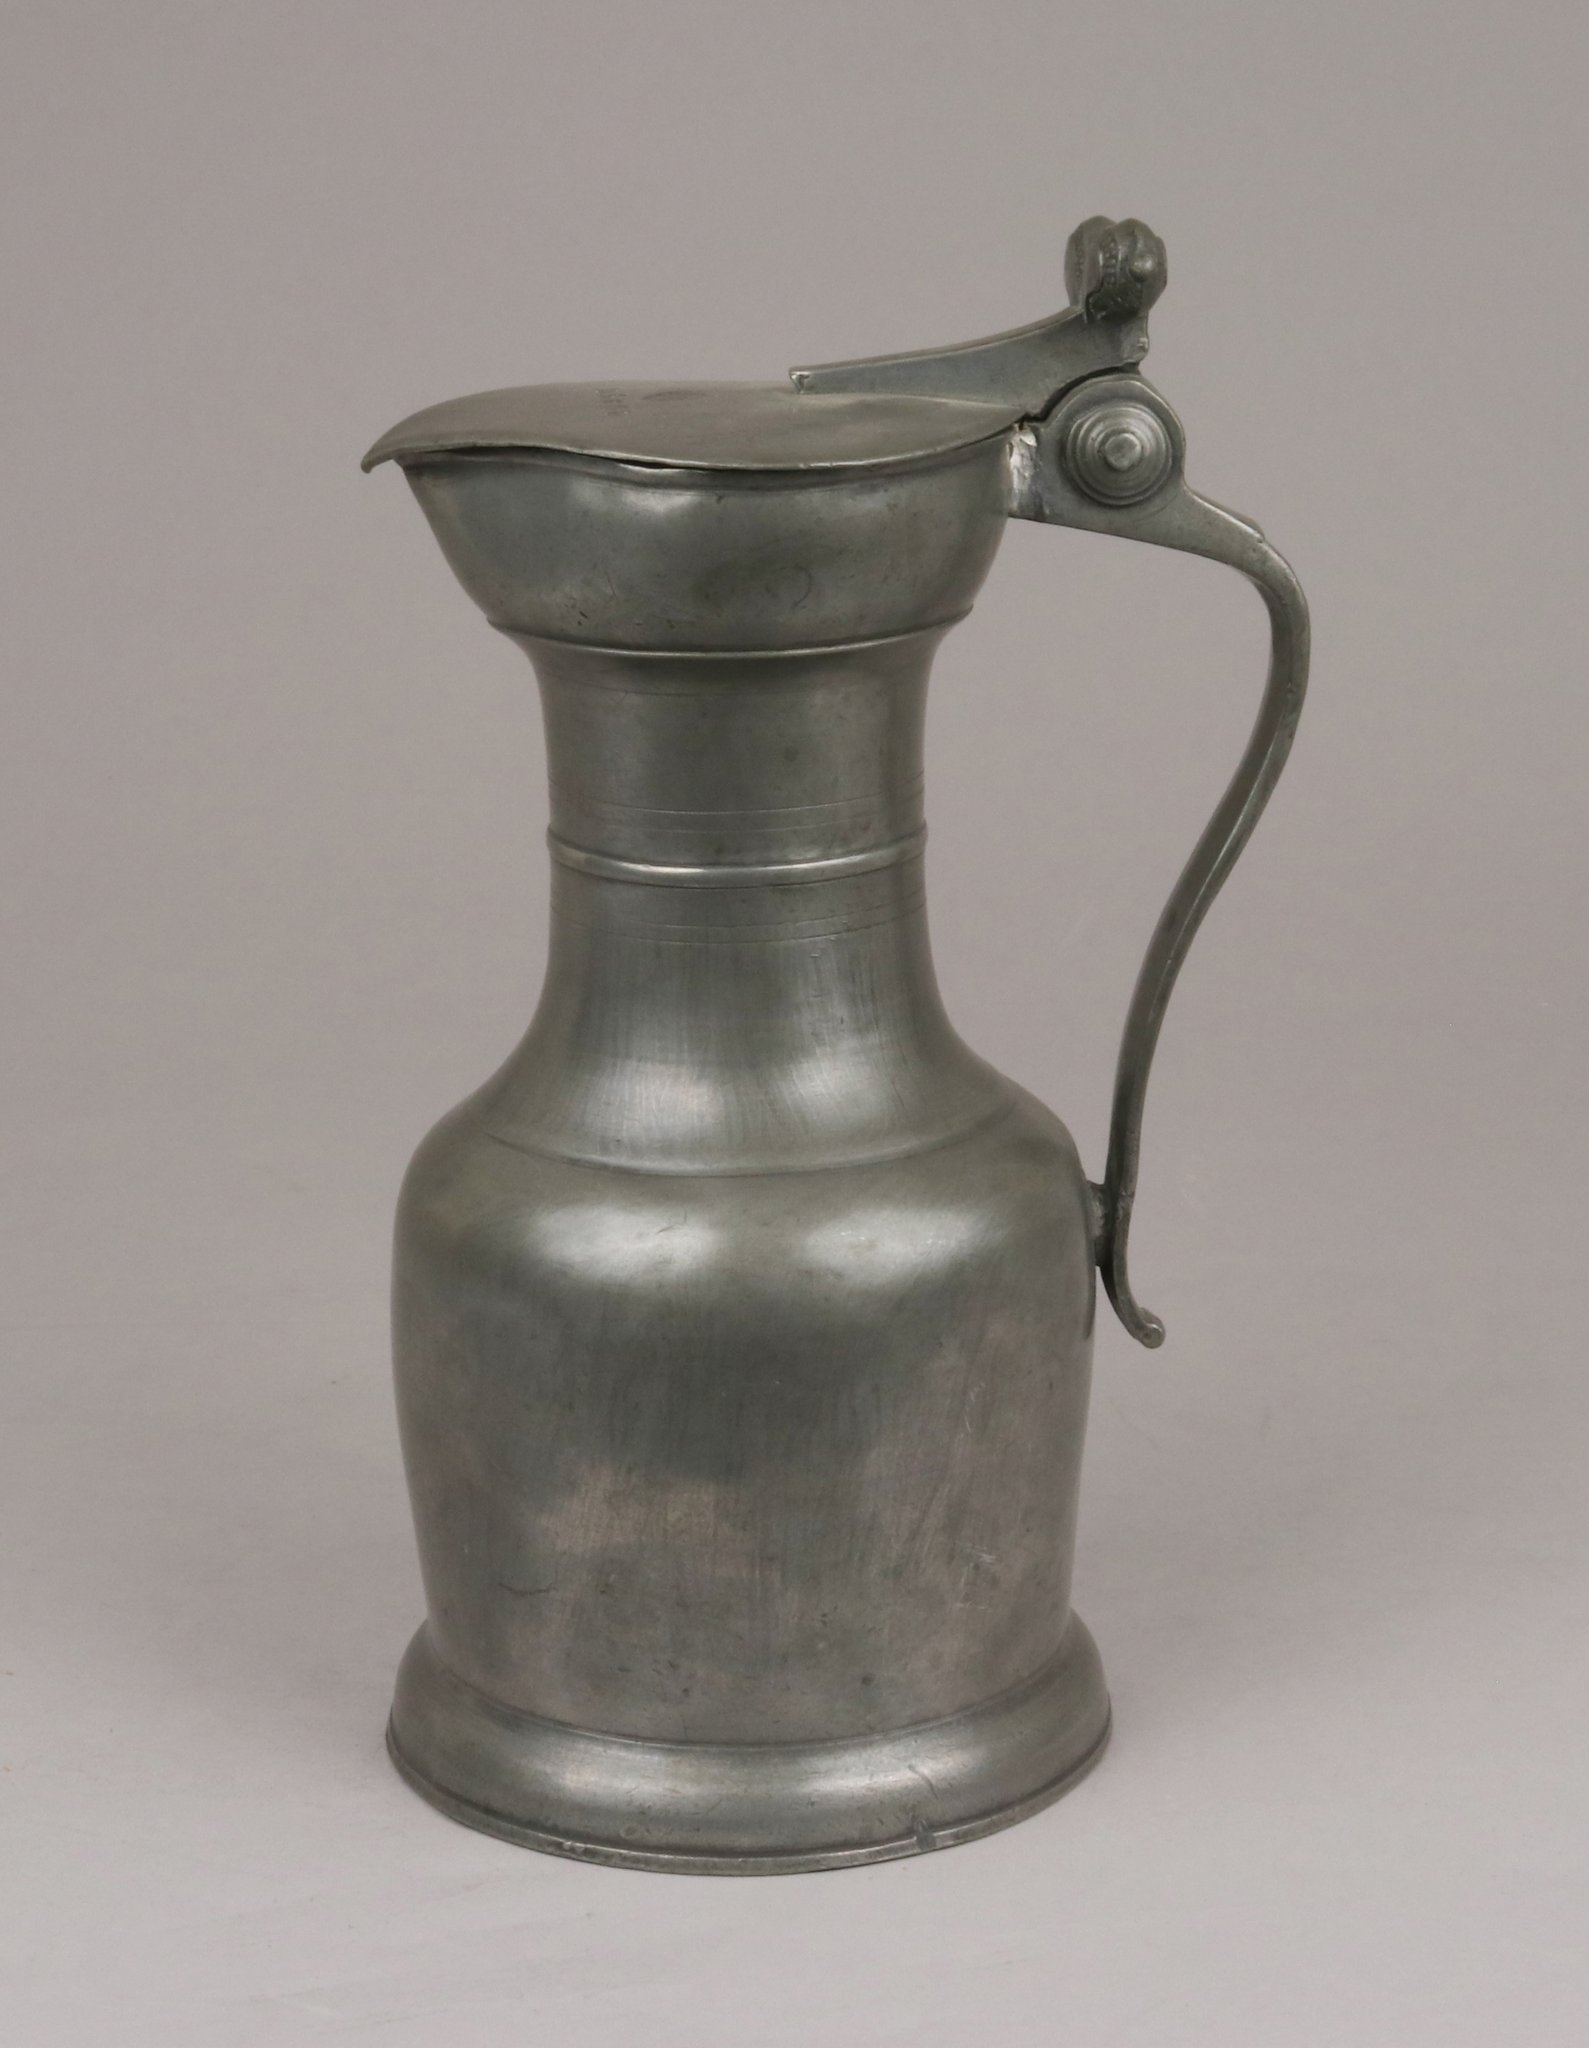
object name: measure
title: Measure (kelchkanne)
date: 1701-1900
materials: pewter